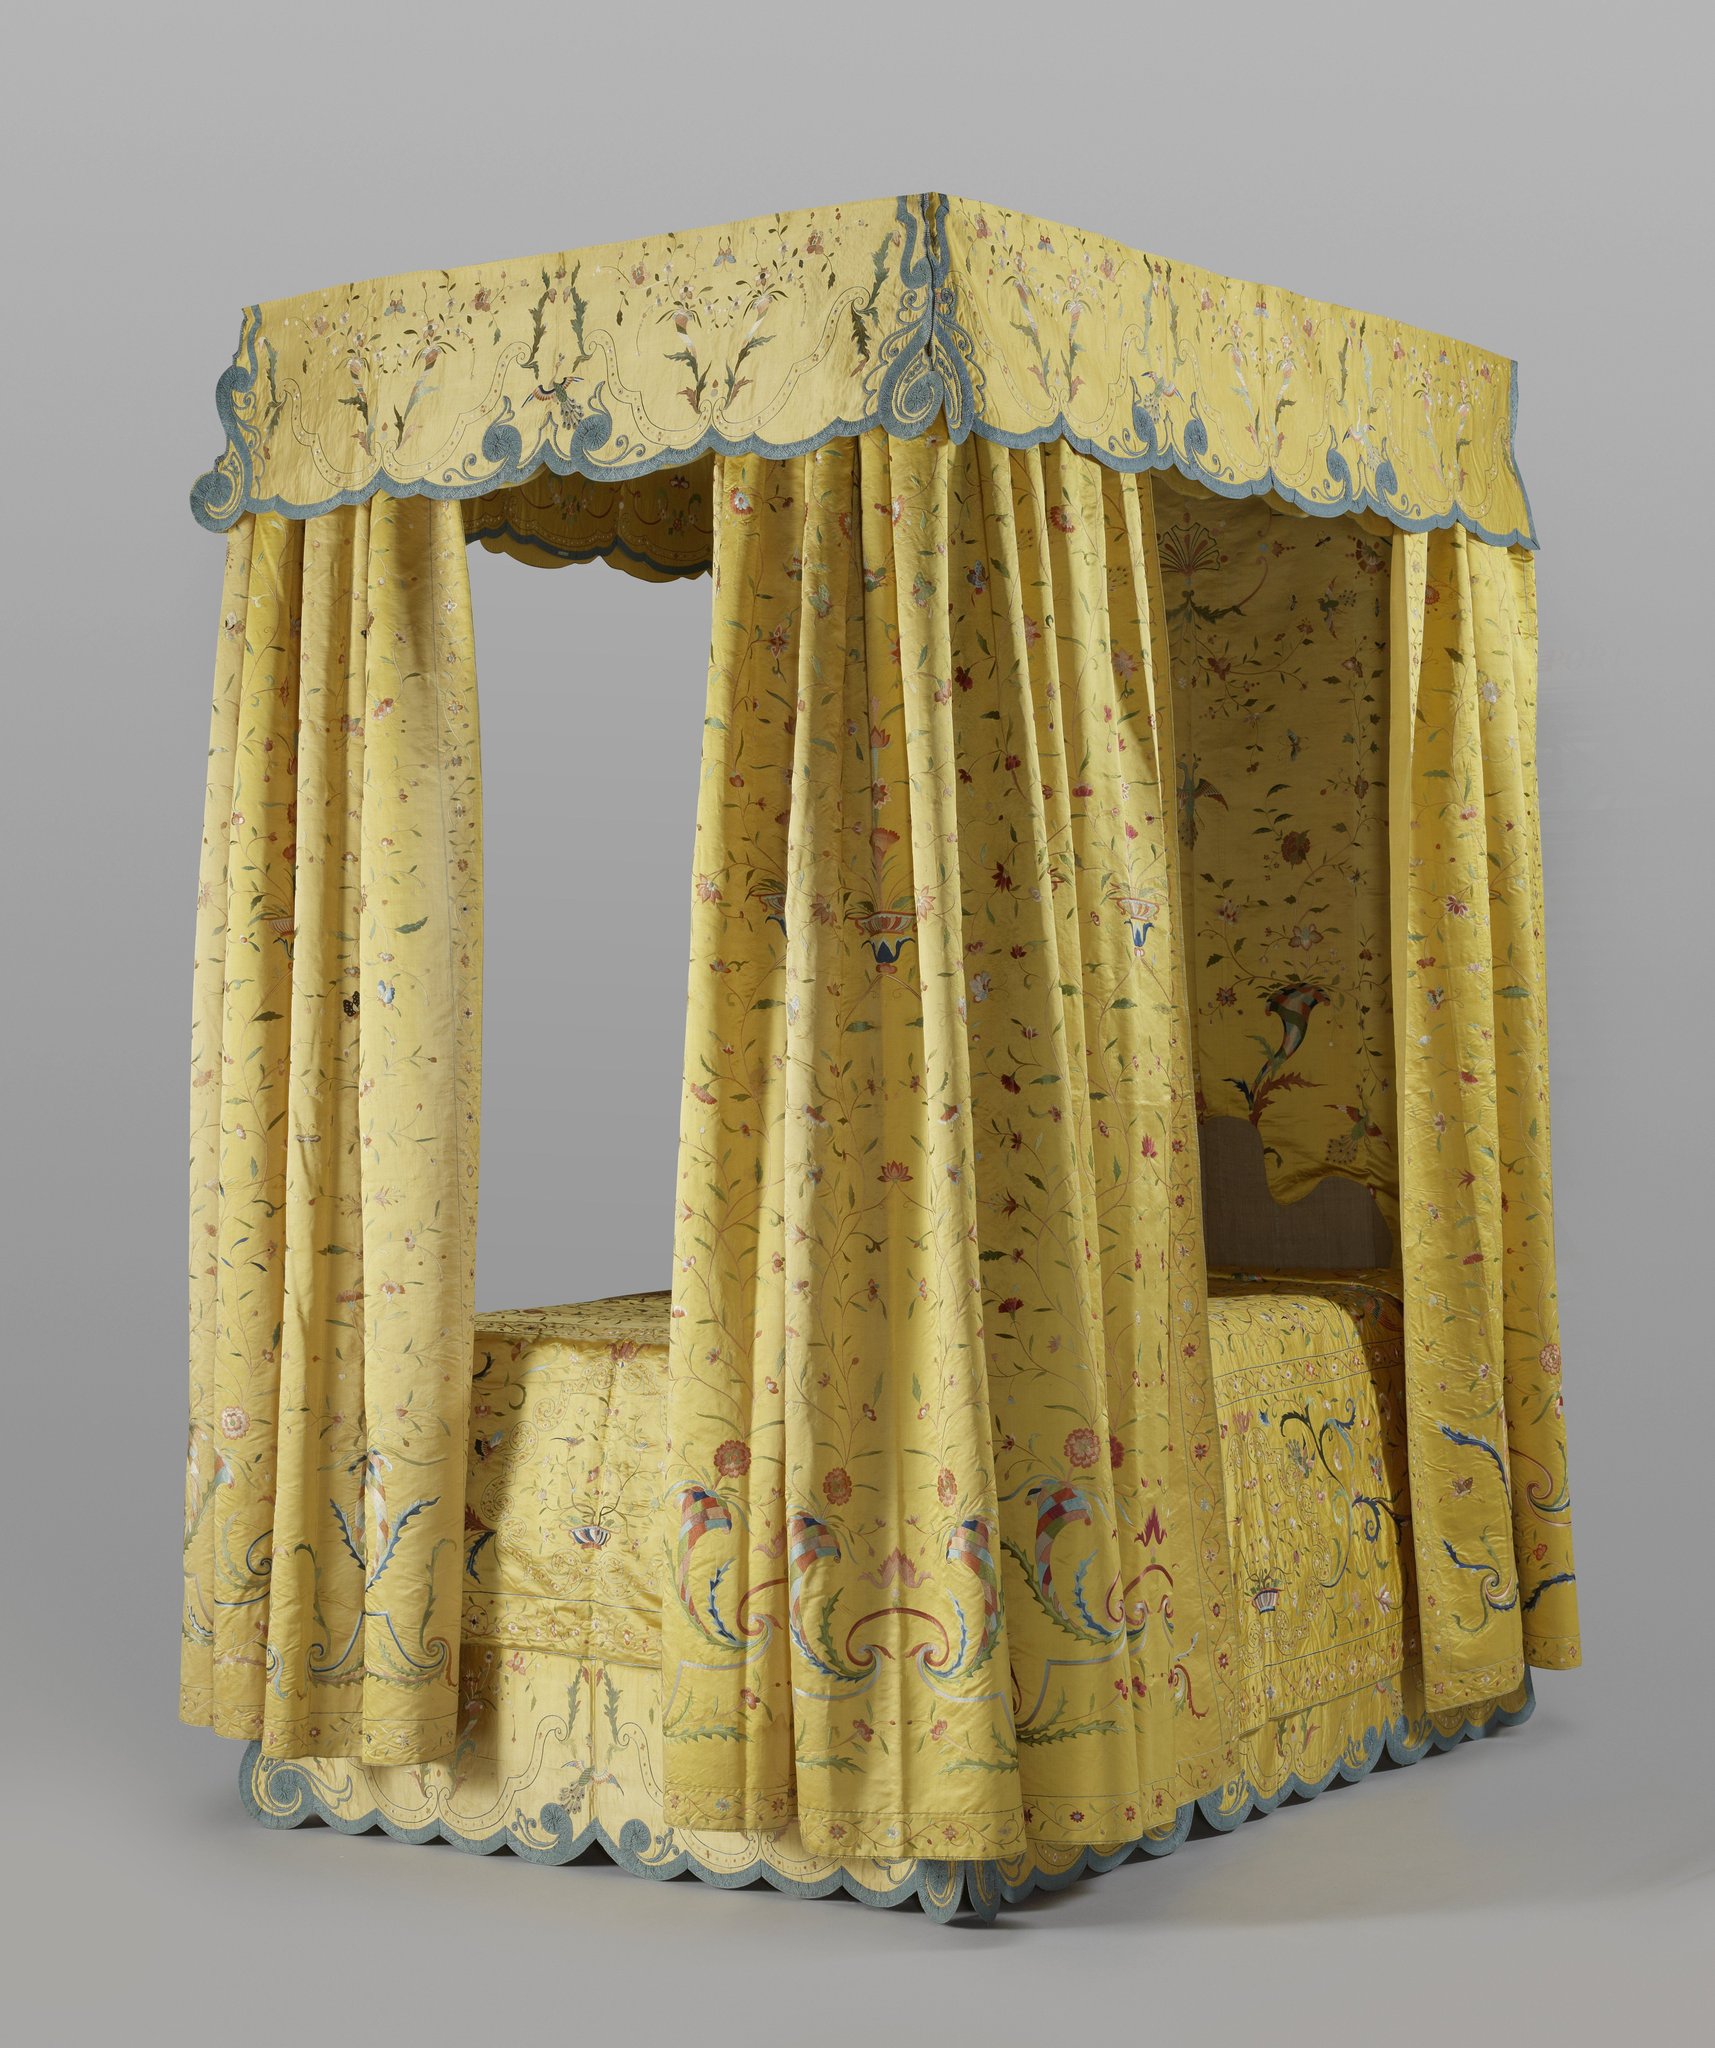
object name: bed covering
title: Bed hangings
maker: Anonymous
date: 1760-1770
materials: linen, silk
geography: guangdong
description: Geel zijden bedgarnituur veelkleurig geborduurd bestaande uit een sprei, achterwand, matrasomhangen, lambrekijns en gordijnen, gevoerd met grof linnen